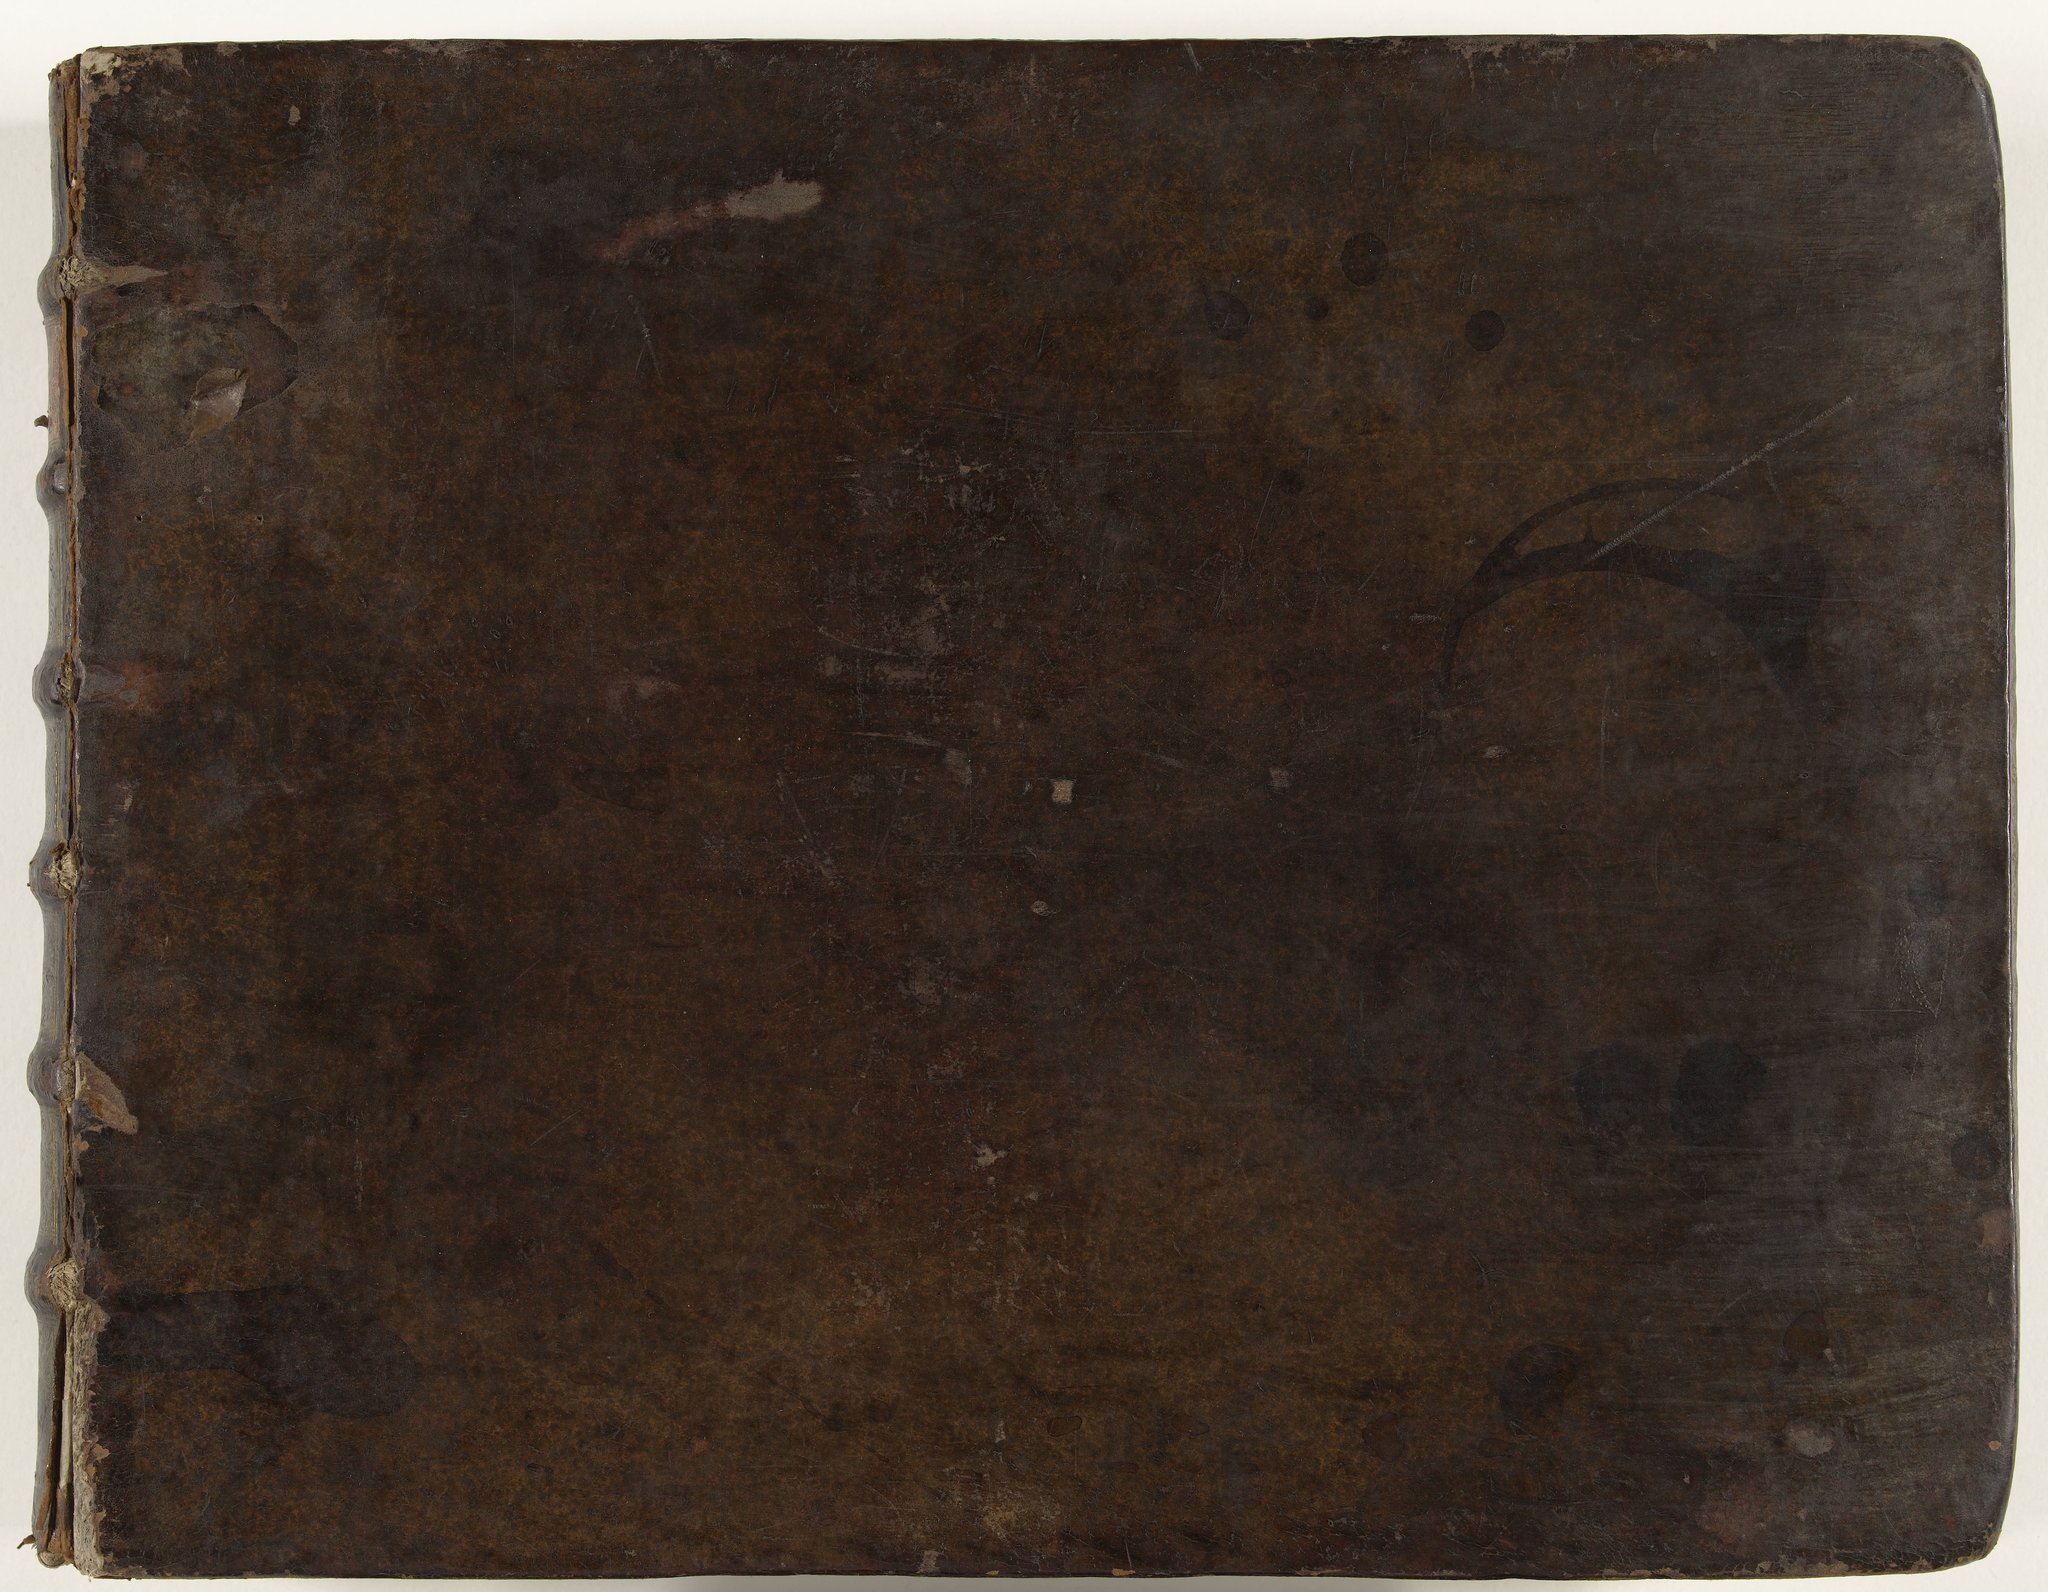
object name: album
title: Forces de l’Europe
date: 1697-1699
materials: cardboard, leather, paper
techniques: engraving, etching, letterpress printing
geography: paris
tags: negenjarige oorlog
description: Verzamelband waarin samen zijn gebonden de acht delen van het prentwerk: Les forces de l'Europe (175 platen) uitgegeven door Nicolas de Fer tussen 1693-1697 (RP-P-OB-83.033A) en de twee delen van het prentwerk: Le Theatre de la Guerre, dans les Pays-Bas (52 platen), ook door Nicolas de Fer uitgegeven in 1696 (RP-P-OB-83.033B). Boekband van donkerbruin leer over karton met op de rug de titel: Forces de l’Europe. Platen met plannen (afkomstig van Sébastien Le Prestre, Seigneur de Vauban) van vermaarde sterke steden en vestingen in de Negenjarige Oorlog. Titels en opschriften in het Frans.